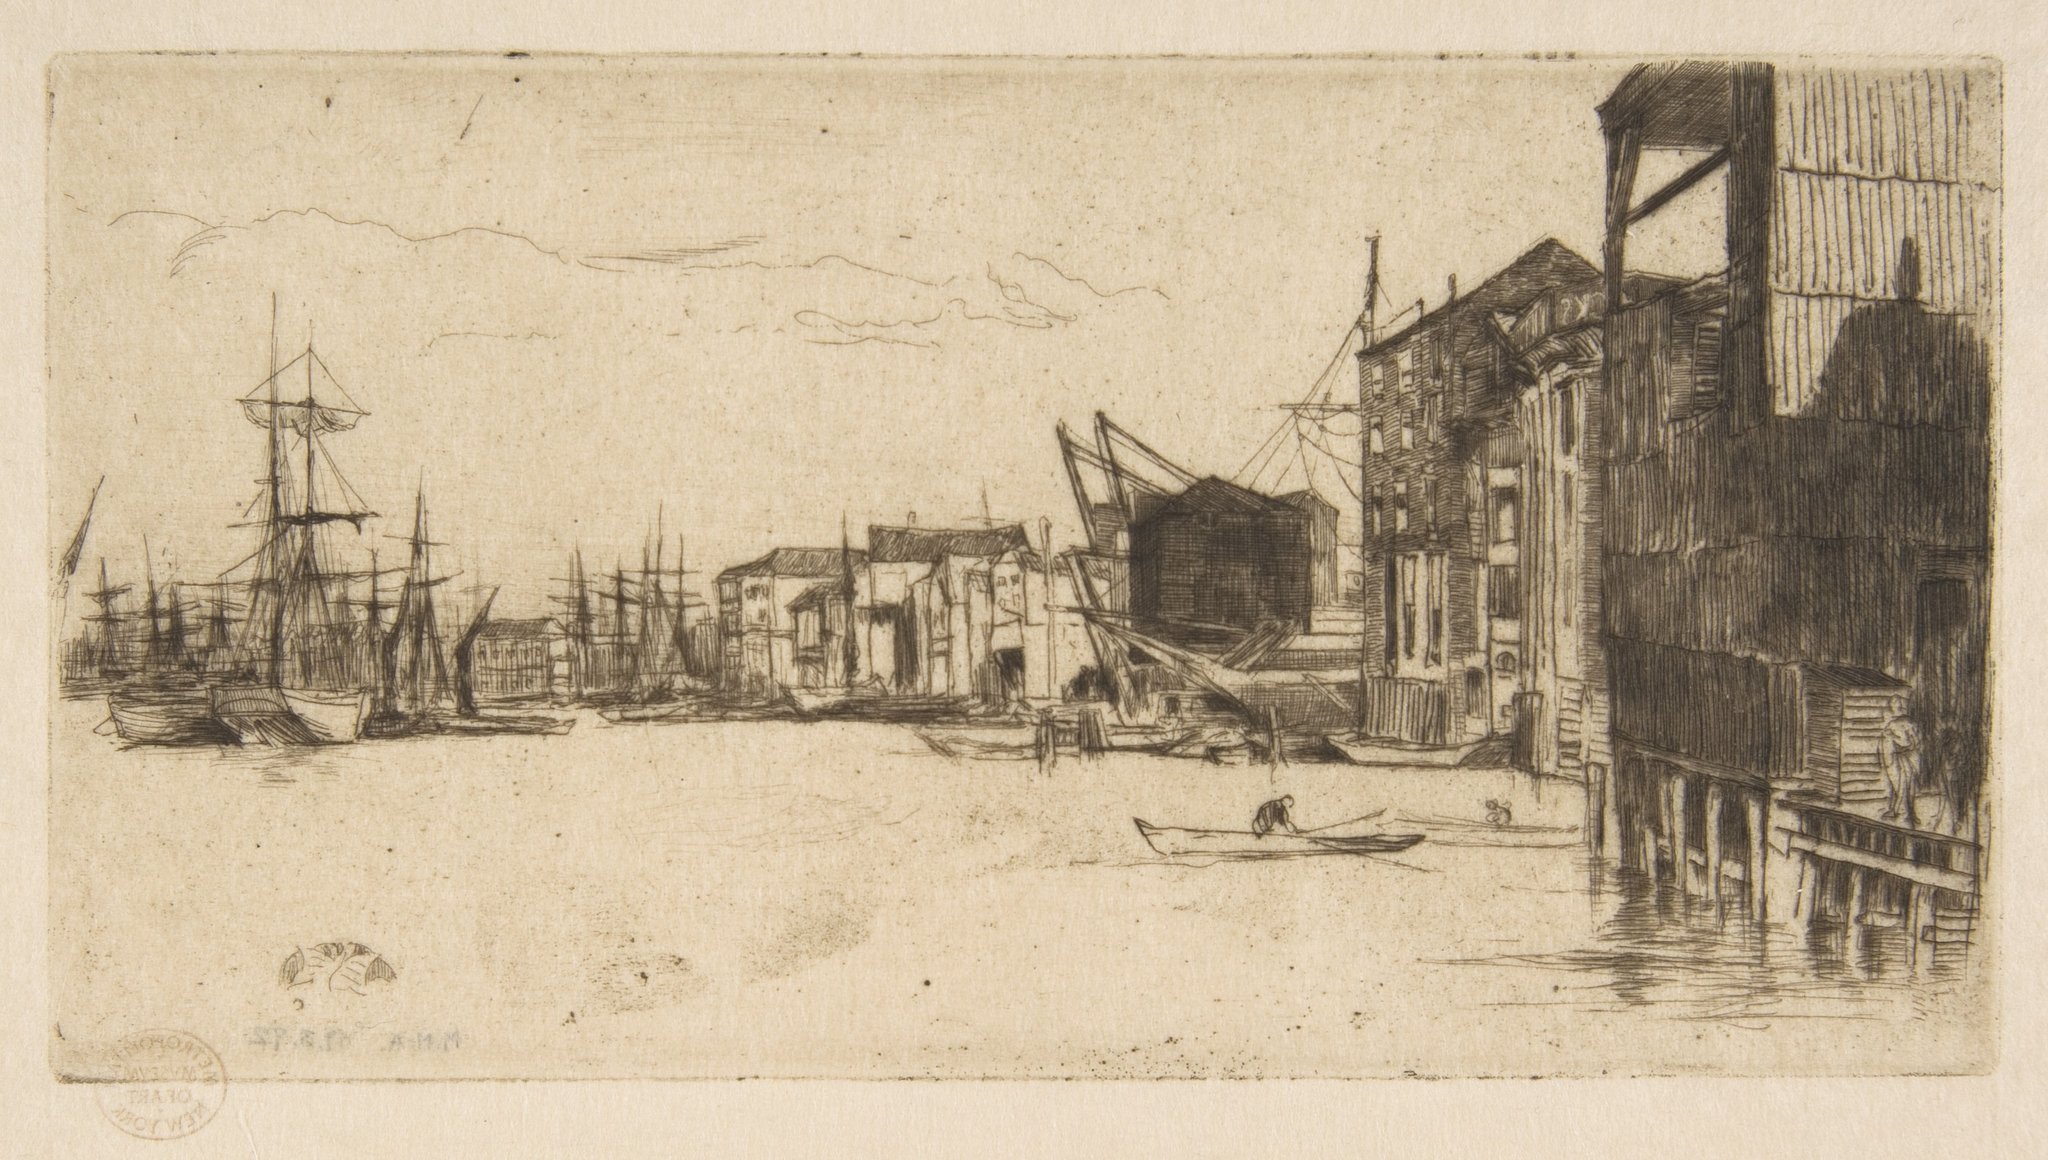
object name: print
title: Free Trade Wharf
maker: james mcneill whistler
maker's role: artist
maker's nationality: american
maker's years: 1834-1903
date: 1877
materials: ink, ivory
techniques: drypoint, etching, printing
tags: docks,rivers,ships